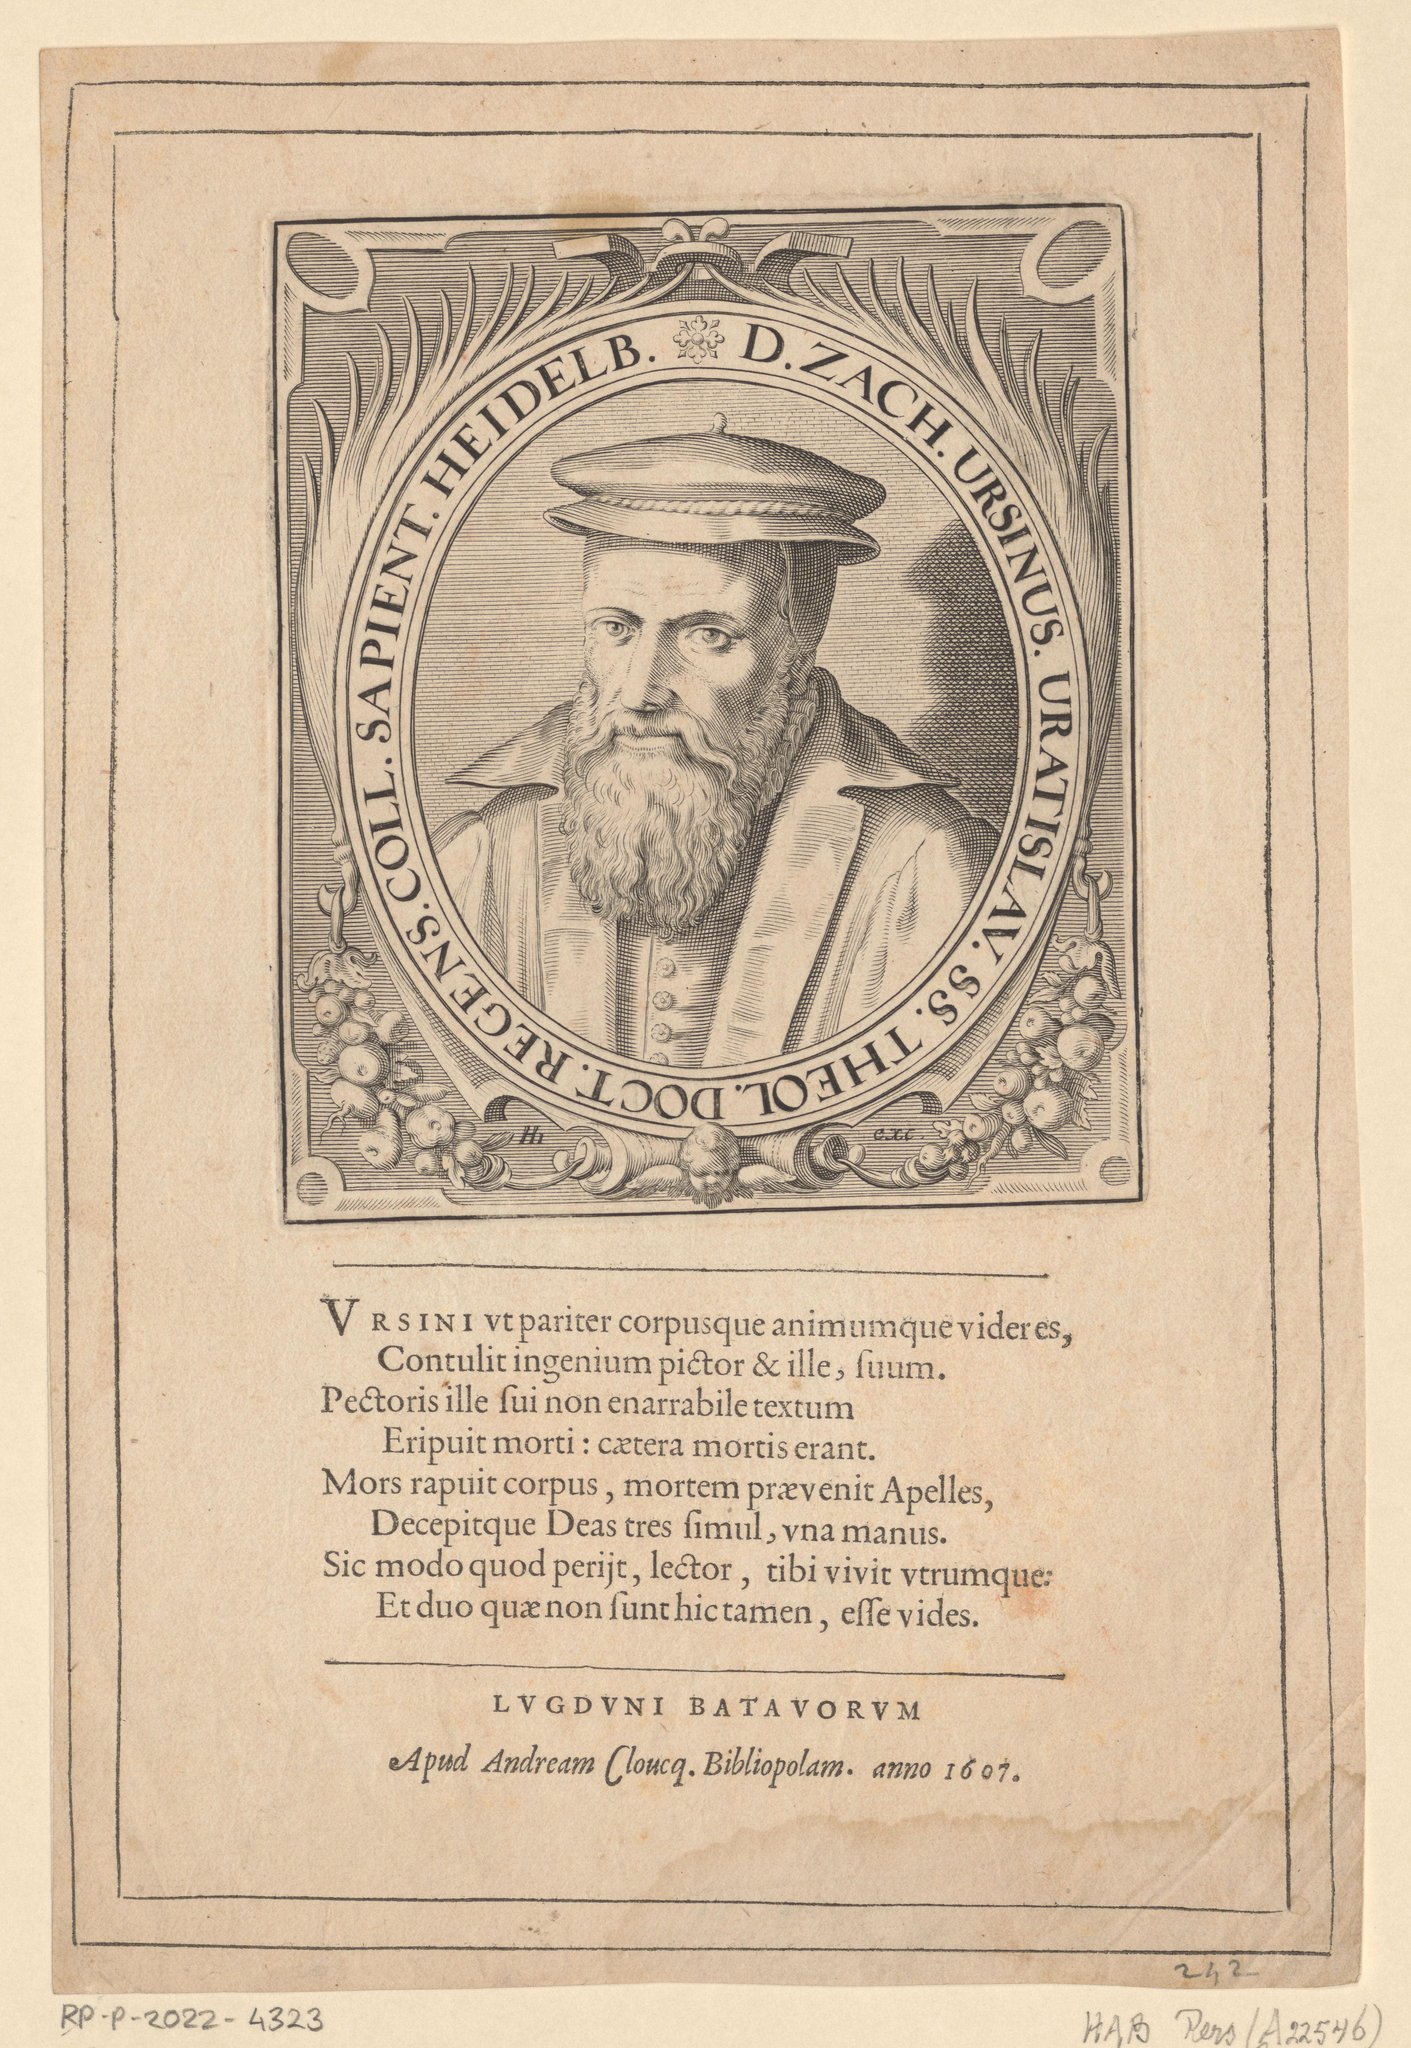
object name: print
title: Portret van Zacharias Ursinus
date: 1607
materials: paper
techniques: engraving, letterpress printing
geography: northern netherlands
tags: theologian, historical persons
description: Eerdere staat van de prent gebruikt in: Ursinus, Zacharias, David Pareus, Festus Hommius, Jermias Bastingius. Het schat-boeck der christelycke leere (...) Leiden: Andries Clouck, 1606.